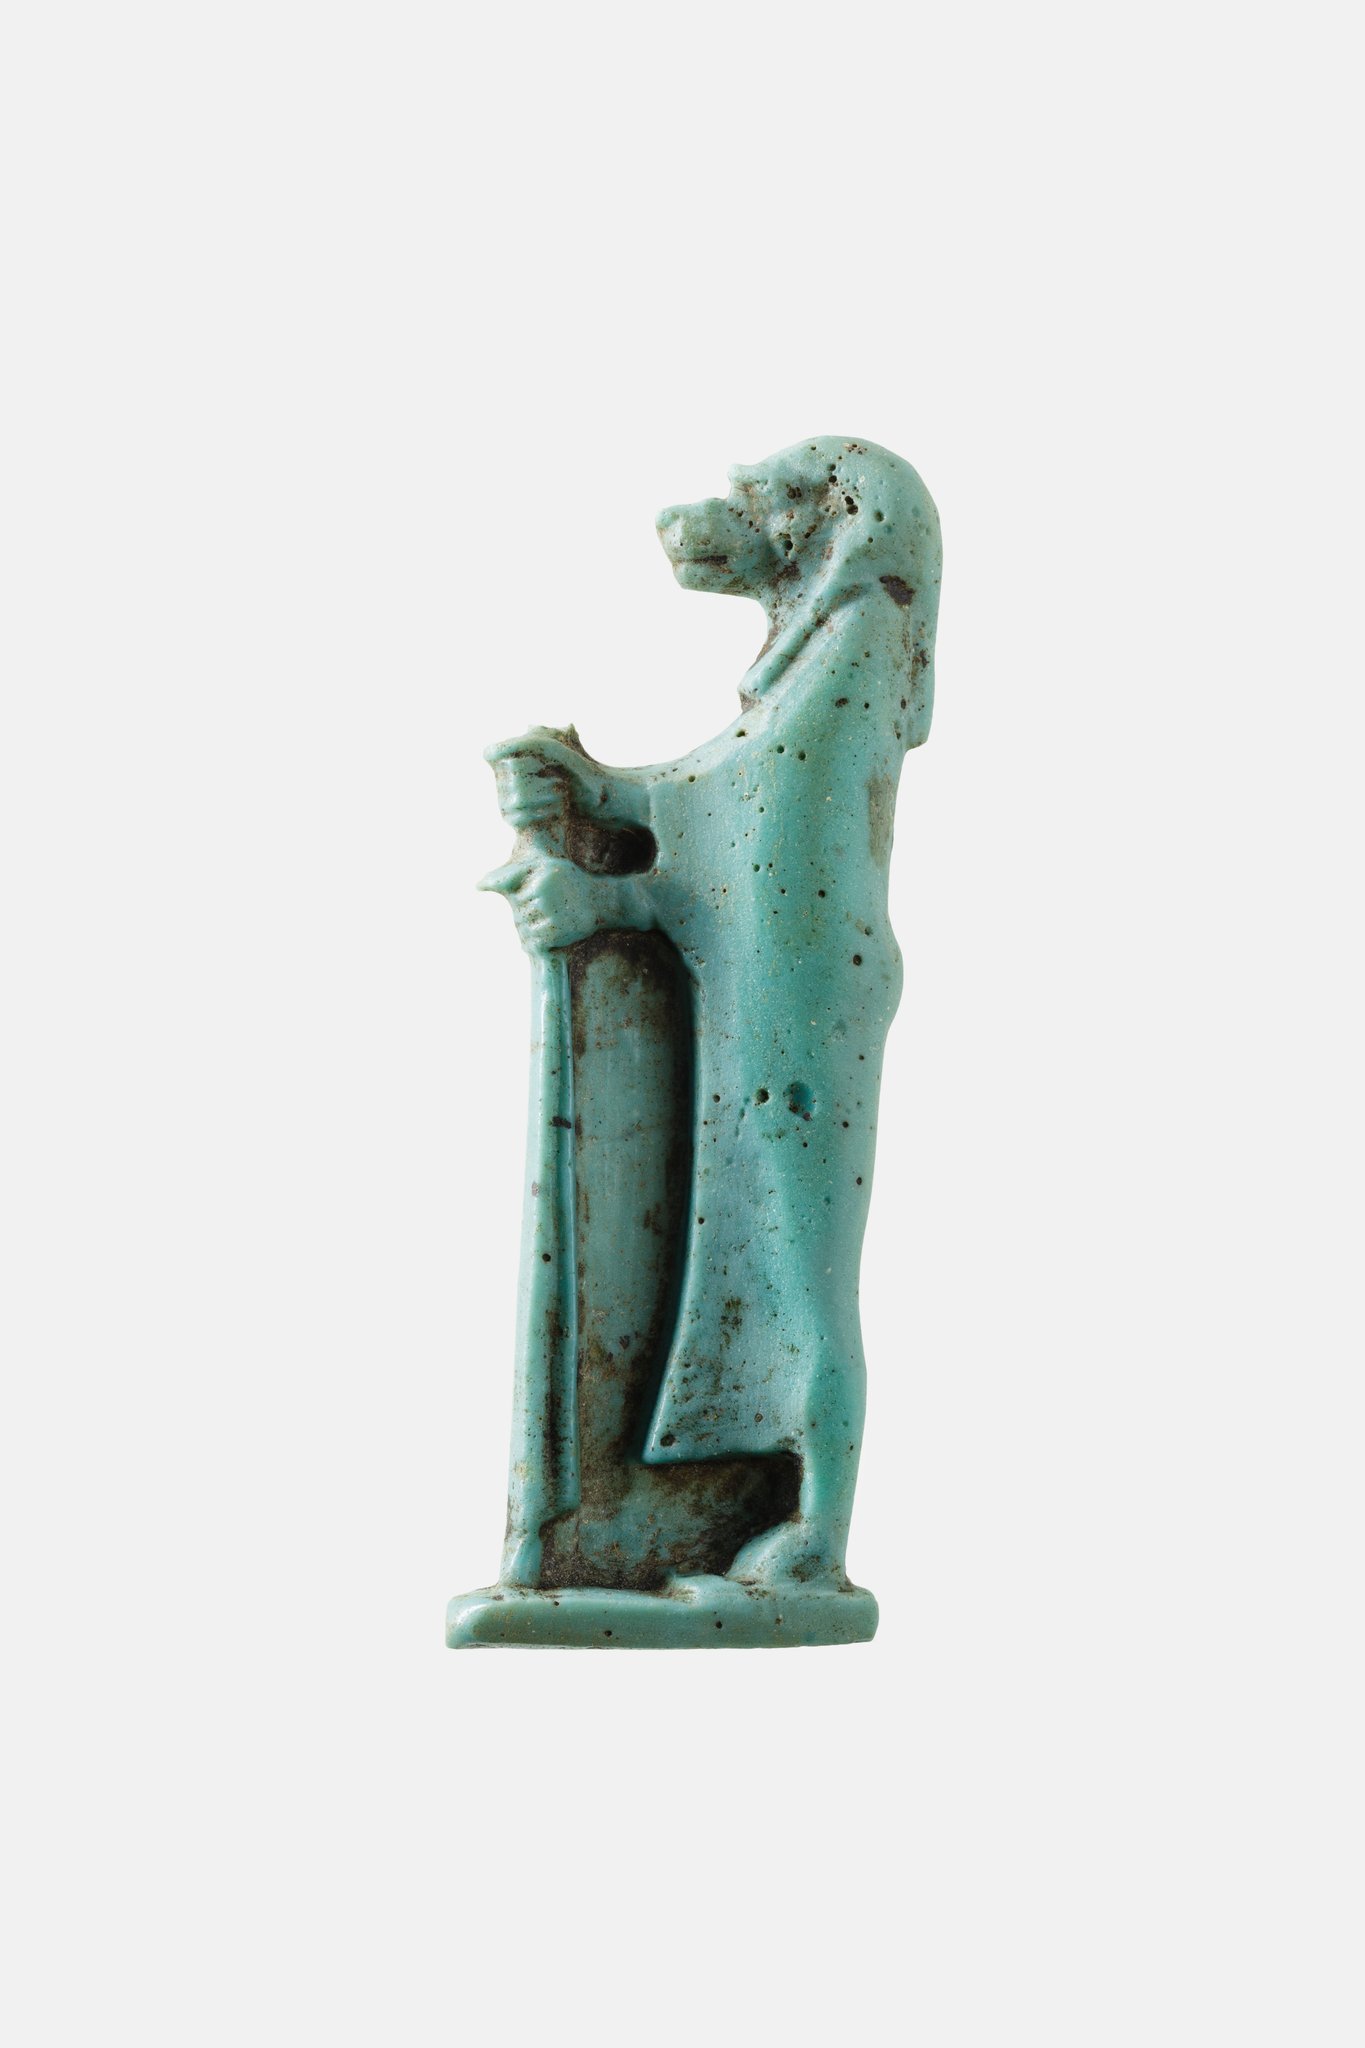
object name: amulet, four son of horus, hapy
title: Funerary amulet depicting one of the Four Sons of Horus, Hapy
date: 332-330 BCE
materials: glass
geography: egypt